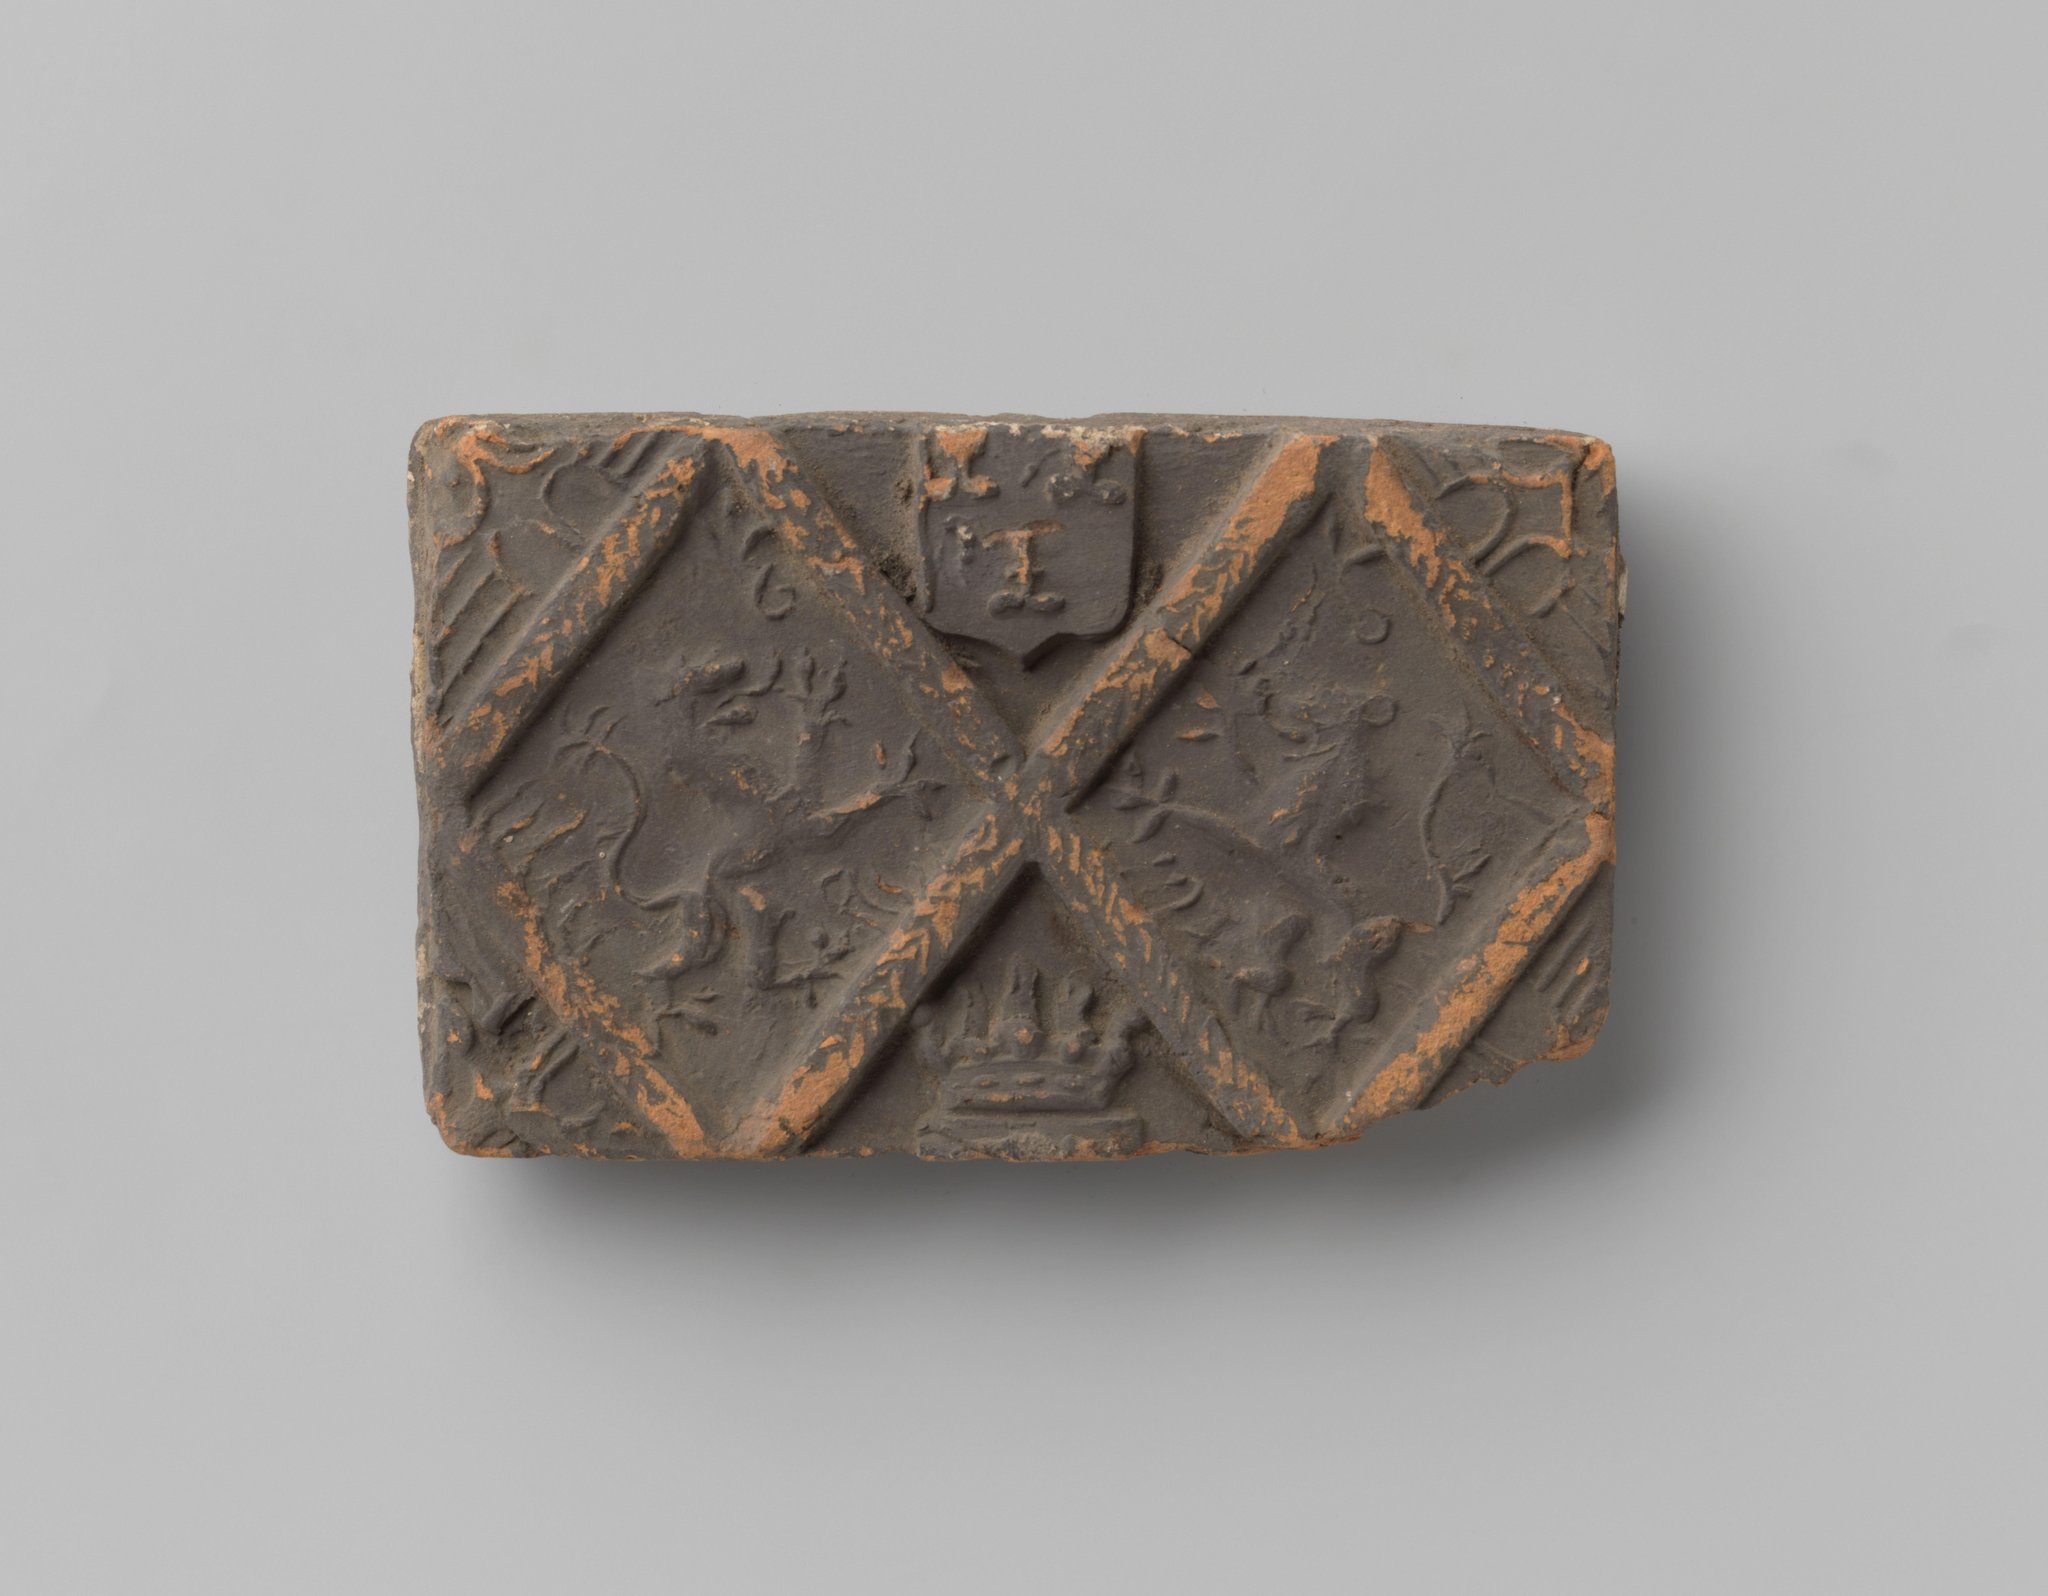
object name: hearthstone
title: Haardsteen met voorstelling van twee klimmende leeuwen en een wapenschild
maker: Anonymous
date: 1610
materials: earthenware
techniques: printing, firing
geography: southern netherlands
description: Haardsteen met voorstelling van twee klimmende leeuwen en het jaartal 1610, geplaatst in geprofileerde ruit. De halve ruiten aan de boven- en onderkant zijn opgevuld met een wapen, een kroon en stermotief.